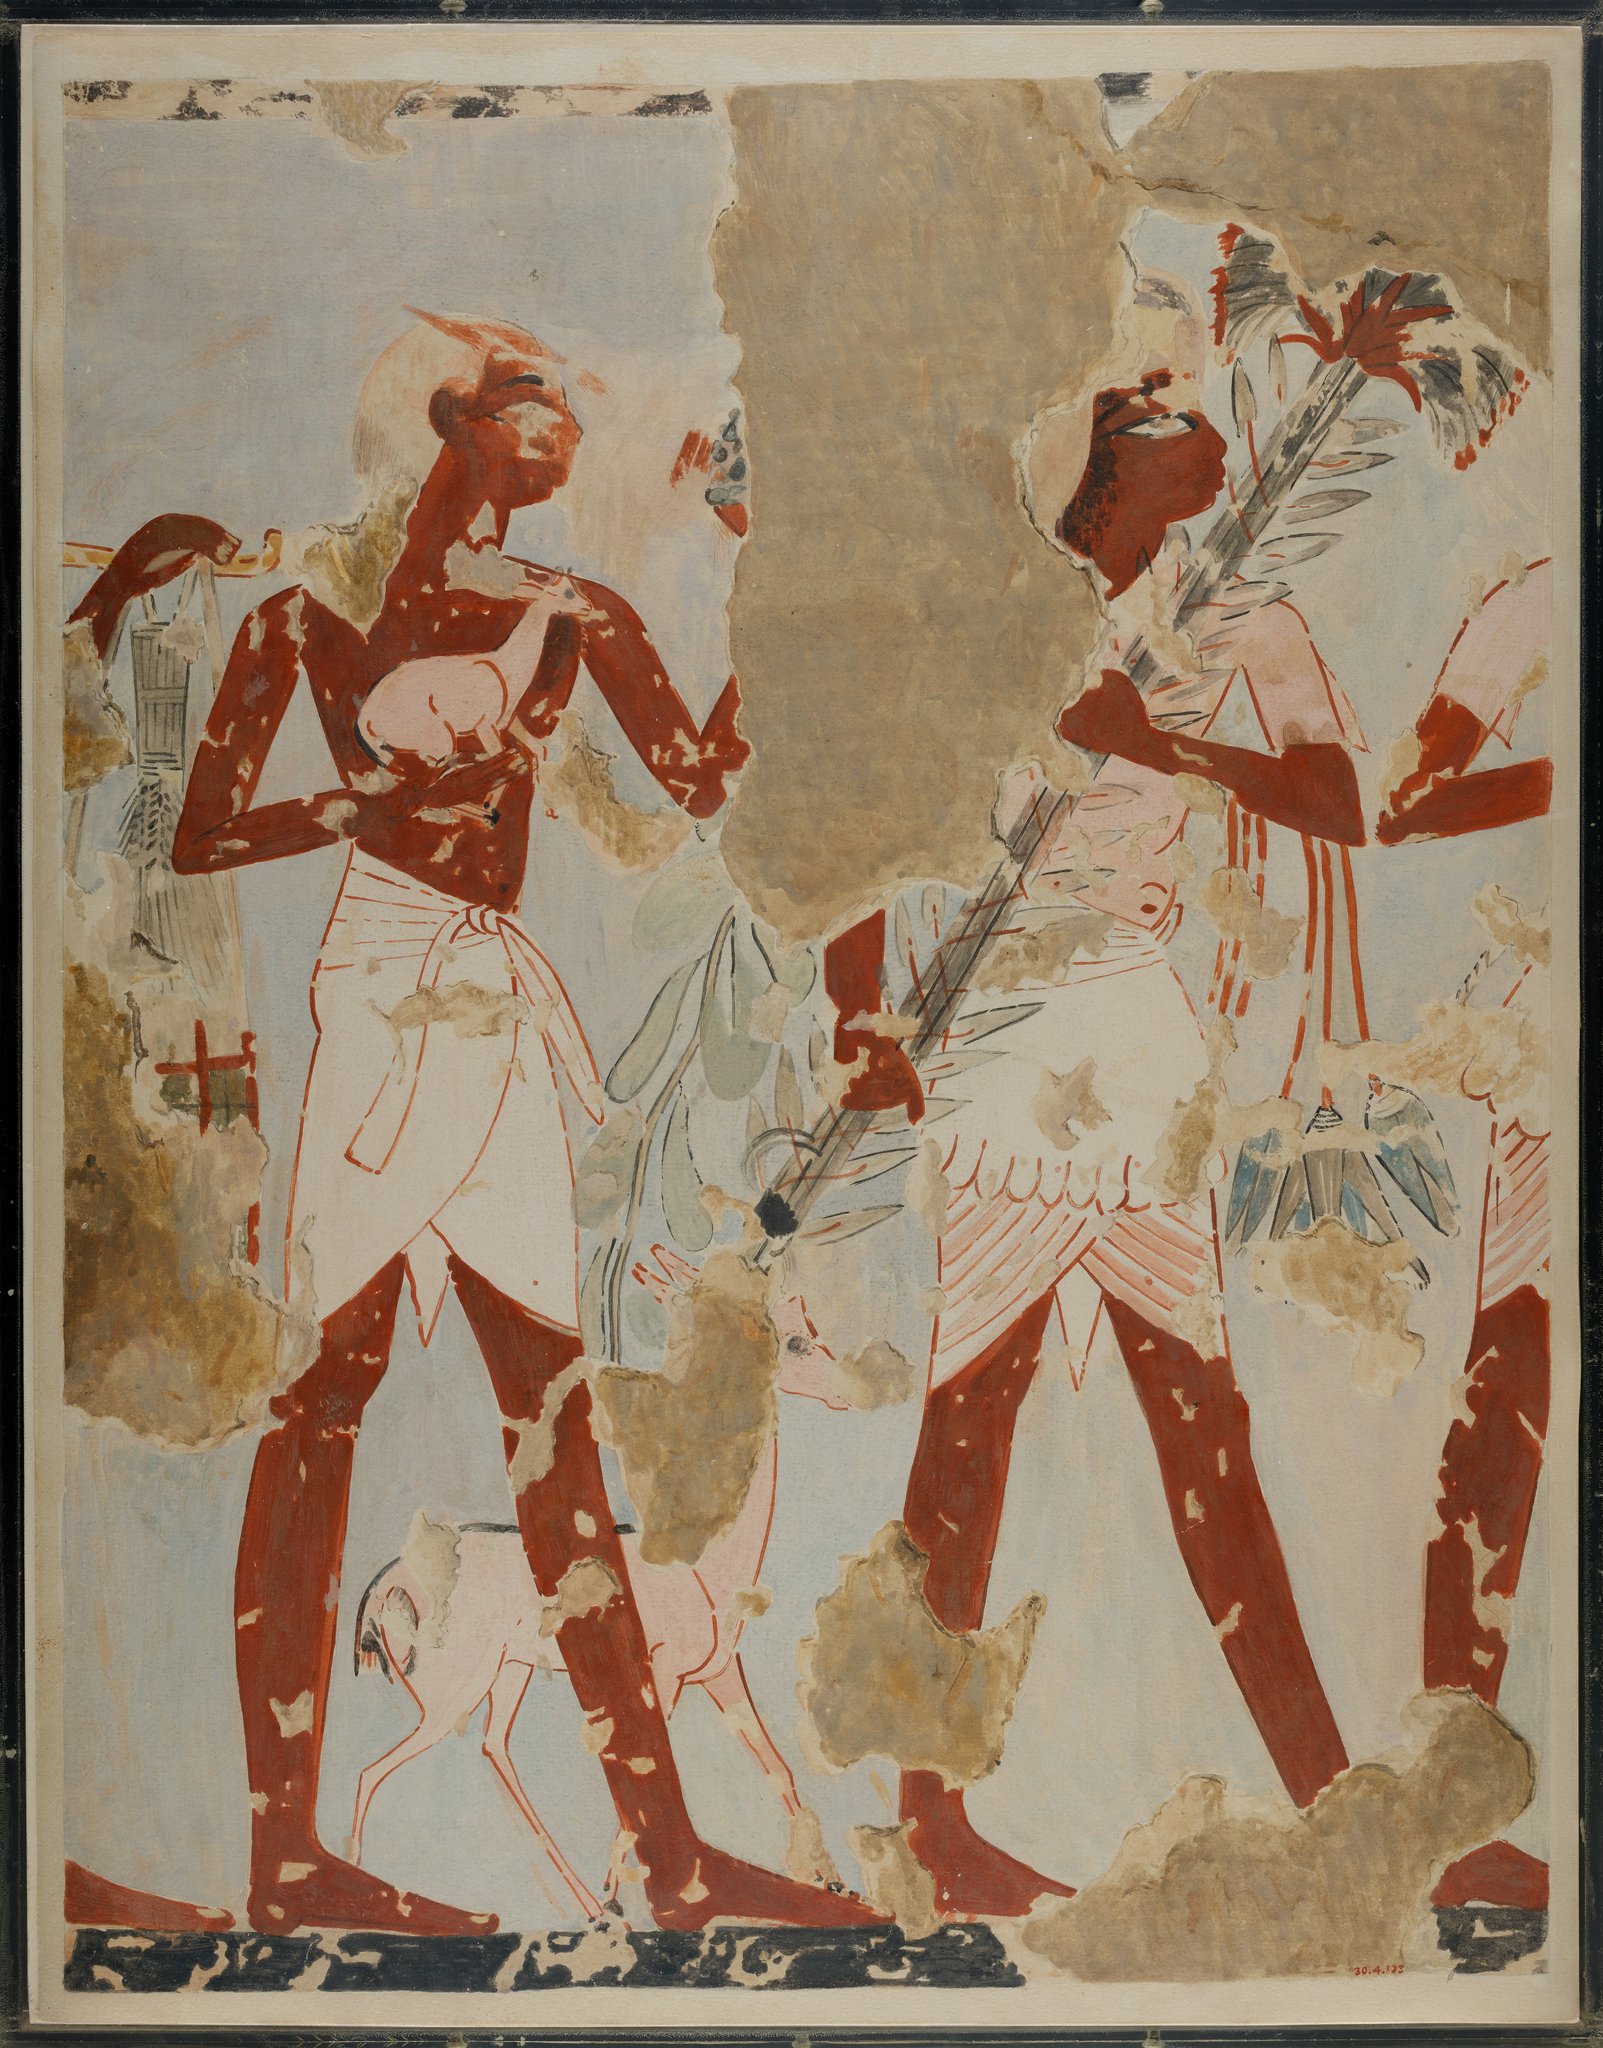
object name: facsimile, qenamun tt 162, offering bearer, male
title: Men Bringing Offerings, Tomb of Qenamun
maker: charles k. wilkinson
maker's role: artist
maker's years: 1897-1986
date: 1479-1400 BCE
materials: paper, paint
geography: egypt